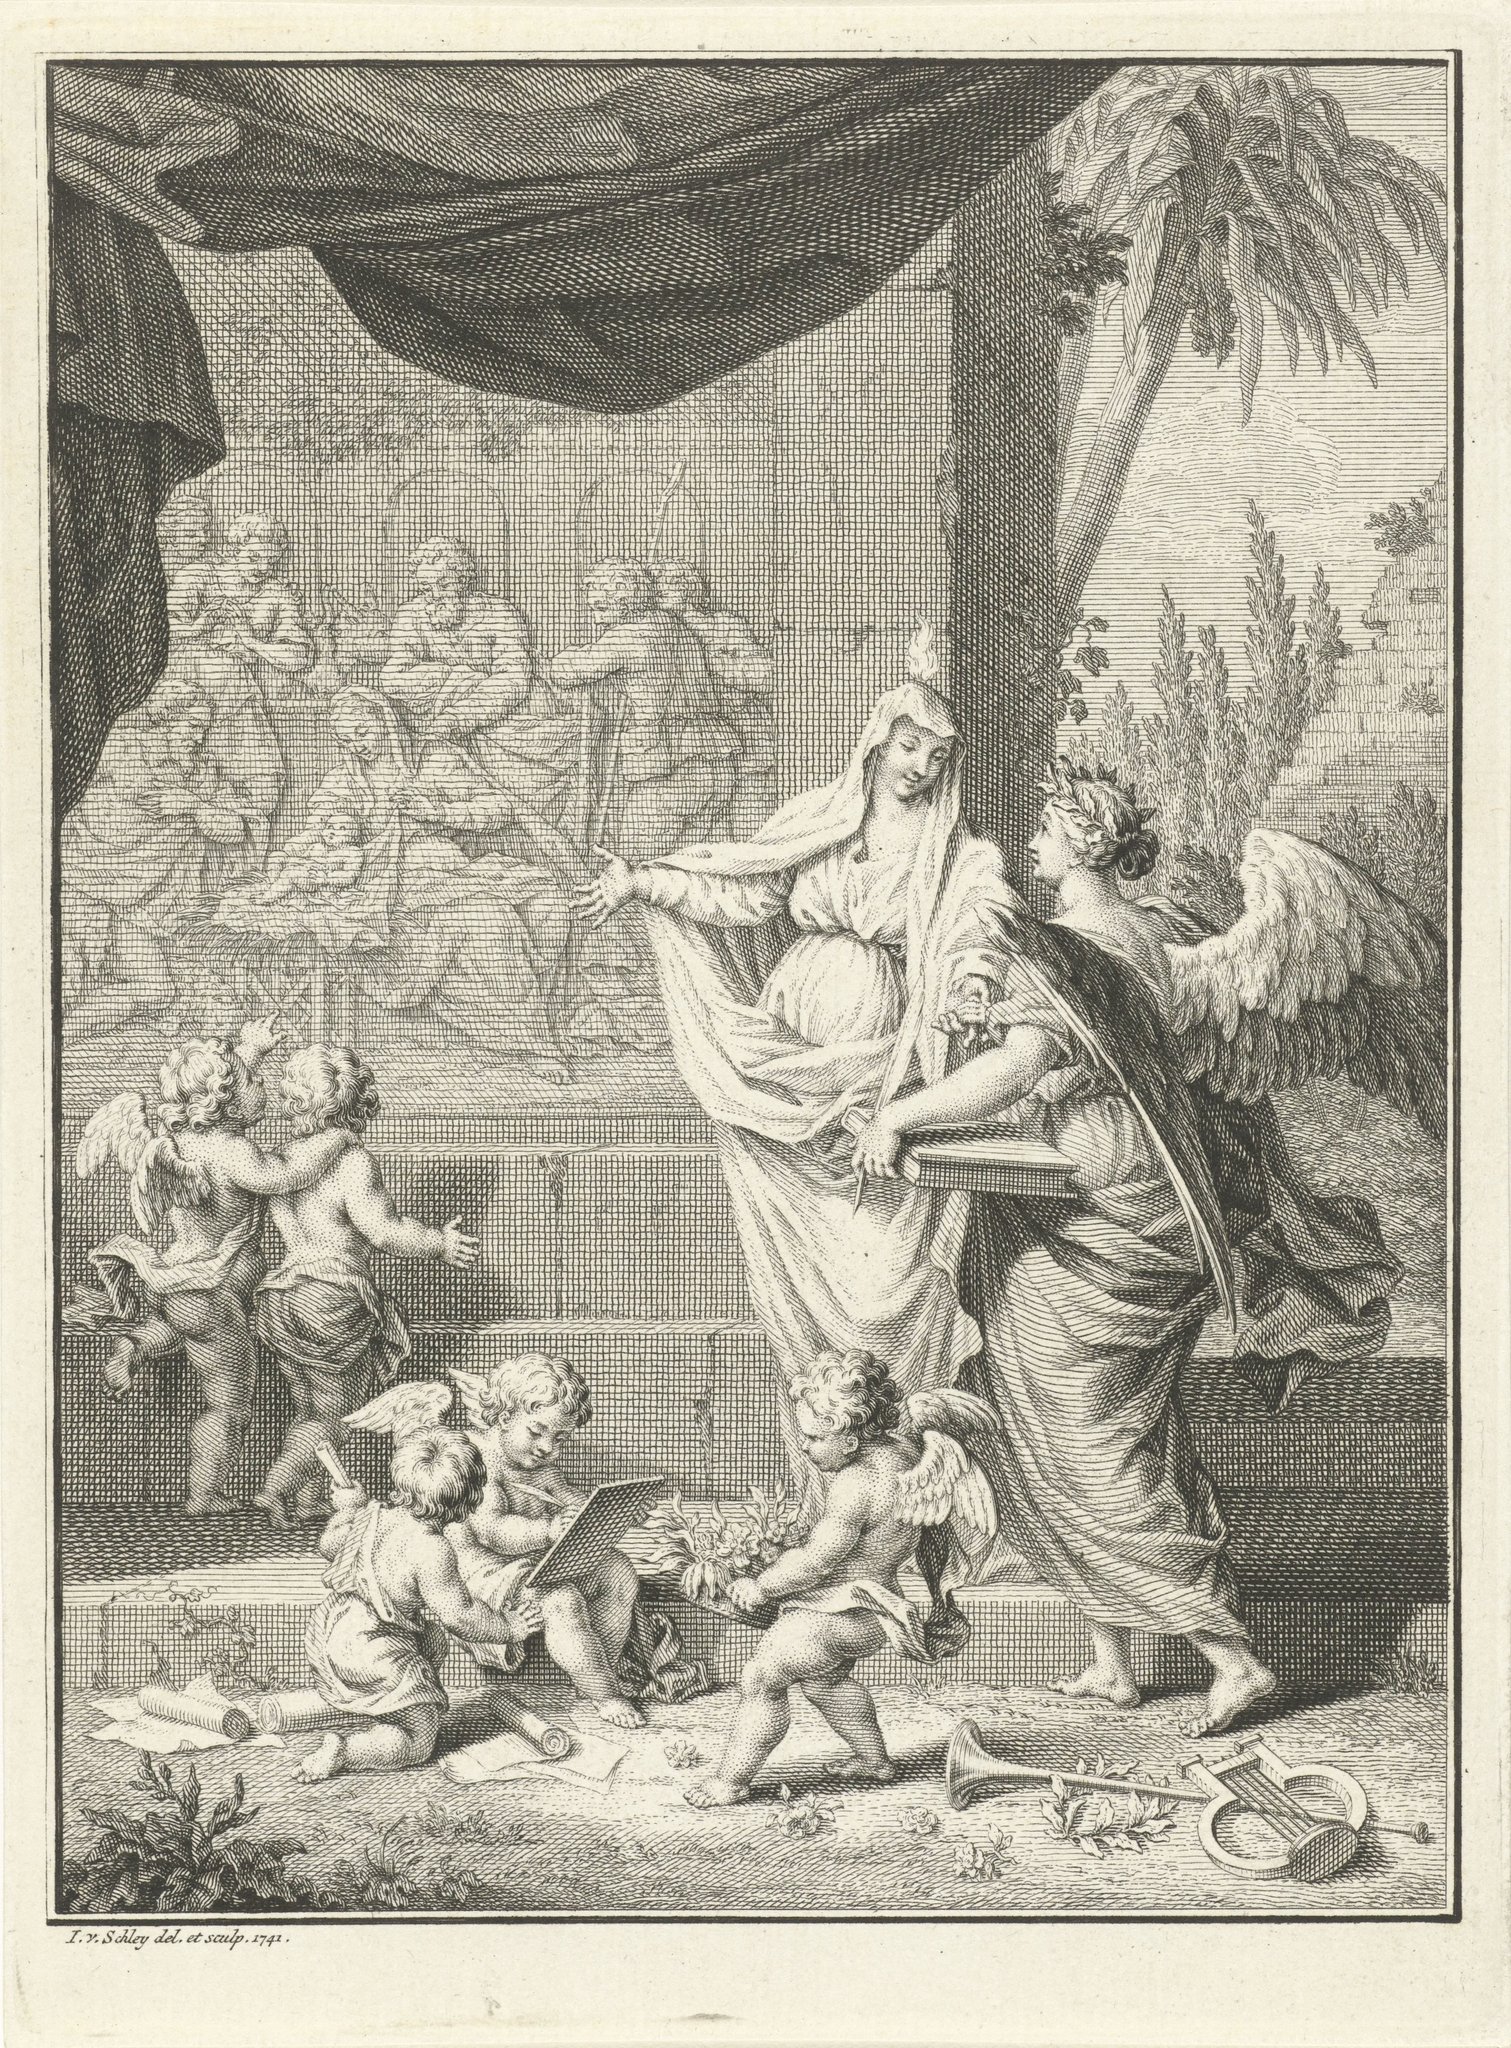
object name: print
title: Waarheid en Geloof voor een reliëf met de aanbidding der herders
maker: jacob van der schley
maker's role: draughtsman, print maker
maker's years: 1715-1779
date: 1741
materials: paper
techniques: engraving, etching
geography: amsterdam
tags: fides (faith) as roman personification, adoration of the christ-child by the shepherds; mary and joseph present, truth; 'verità' (ripa), cupids: 'amores', 'amoretti', 'putti'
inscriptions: collector's mark: Lugt 2228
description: Voor een reliëf van de aanbidding der herders staan personificaties van de Waarheid en Geloof en vijf engeltjes. Op de voorgrond liggen een lier en een bazuin.